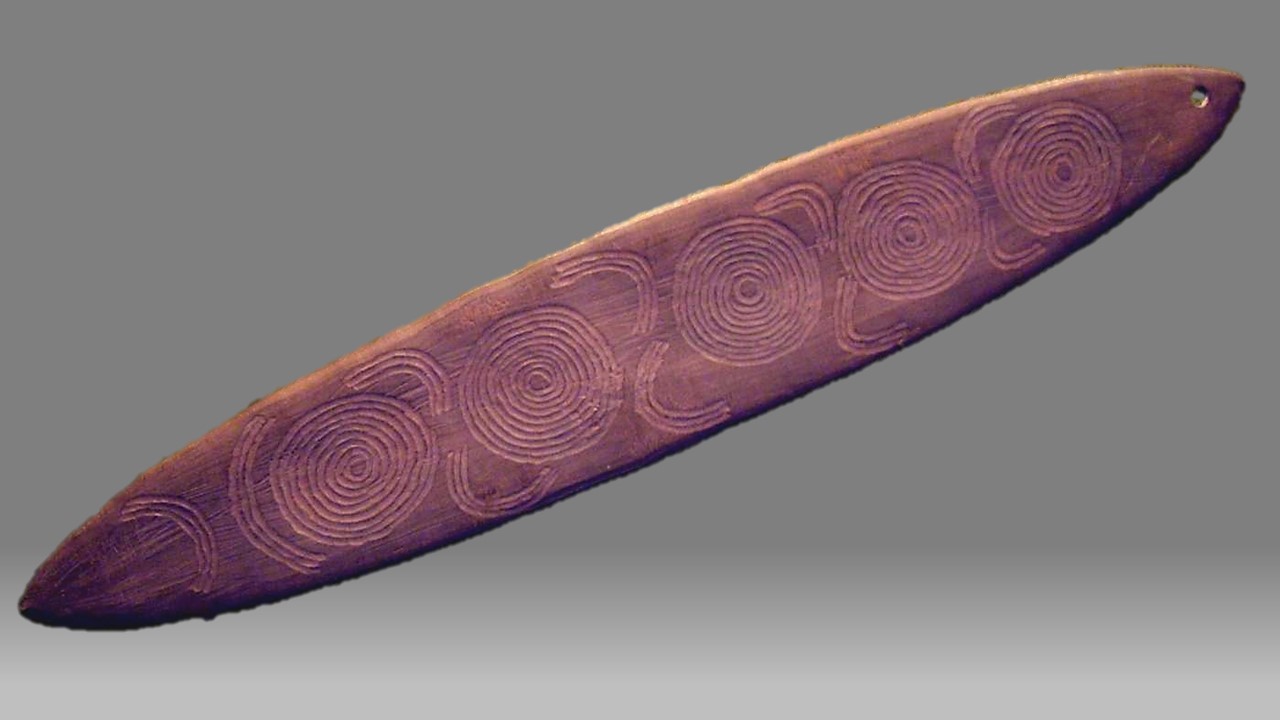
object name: wilmurra bull roarer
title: Wilmurra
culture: algamurra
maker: algamurra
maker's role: culture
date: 1801-1900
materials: wood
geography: australia